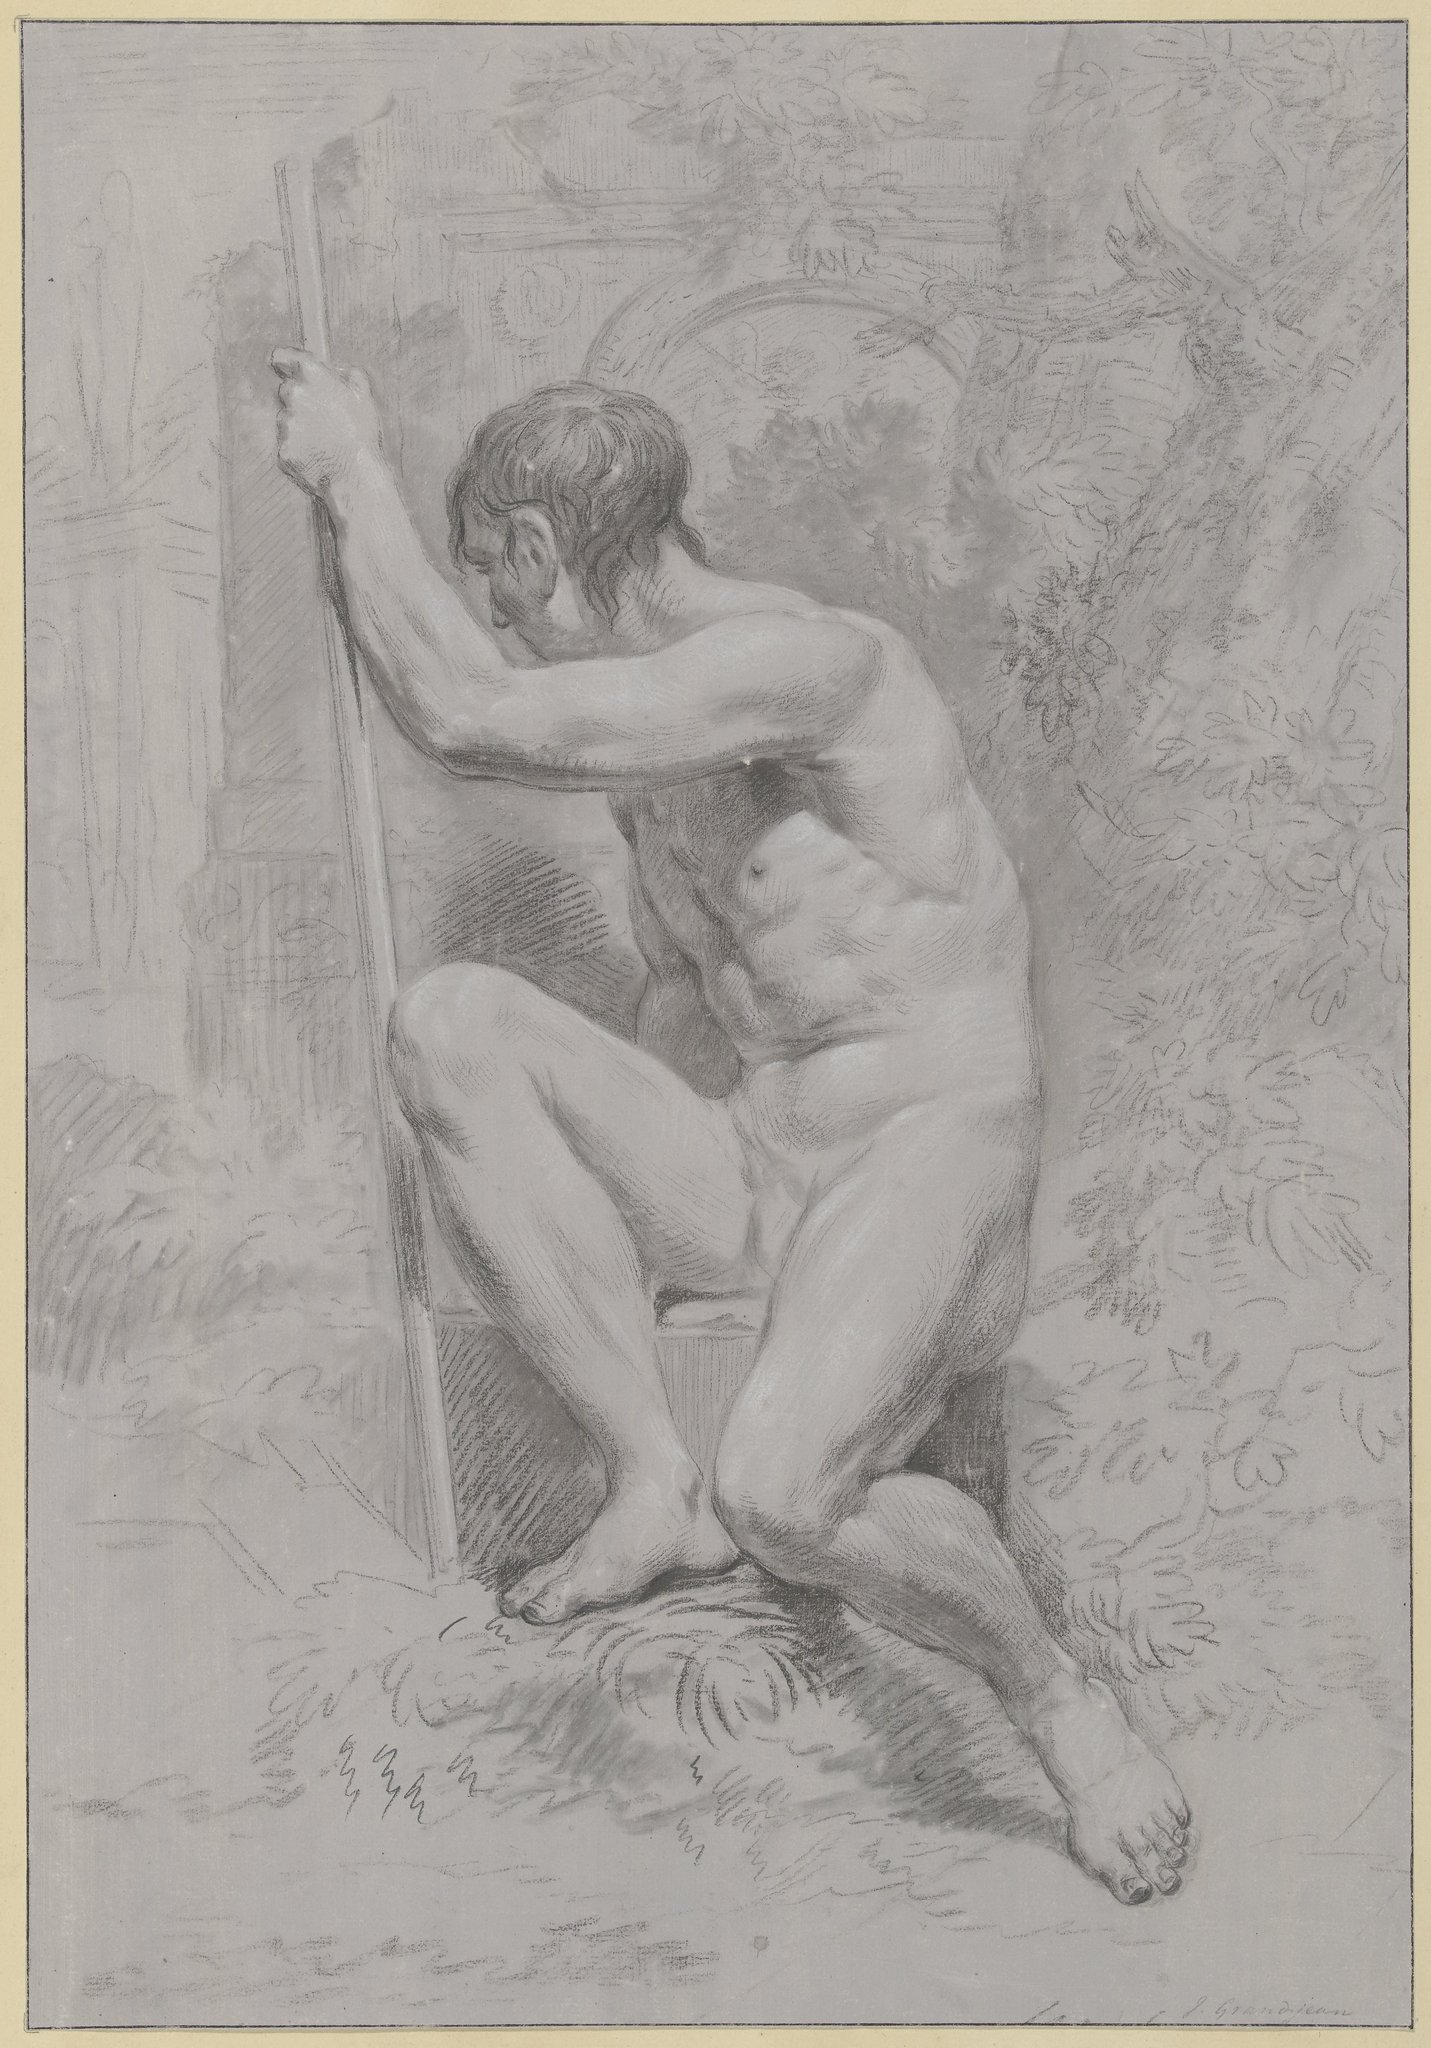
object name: drawing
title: Zittend mannelijk naakt, met een stok, naar links gedraaid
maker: jean grandjean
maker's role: draughtsman, print maker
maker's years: 1752-1781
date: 1765-1781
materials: chalk, paper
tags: sitting figure